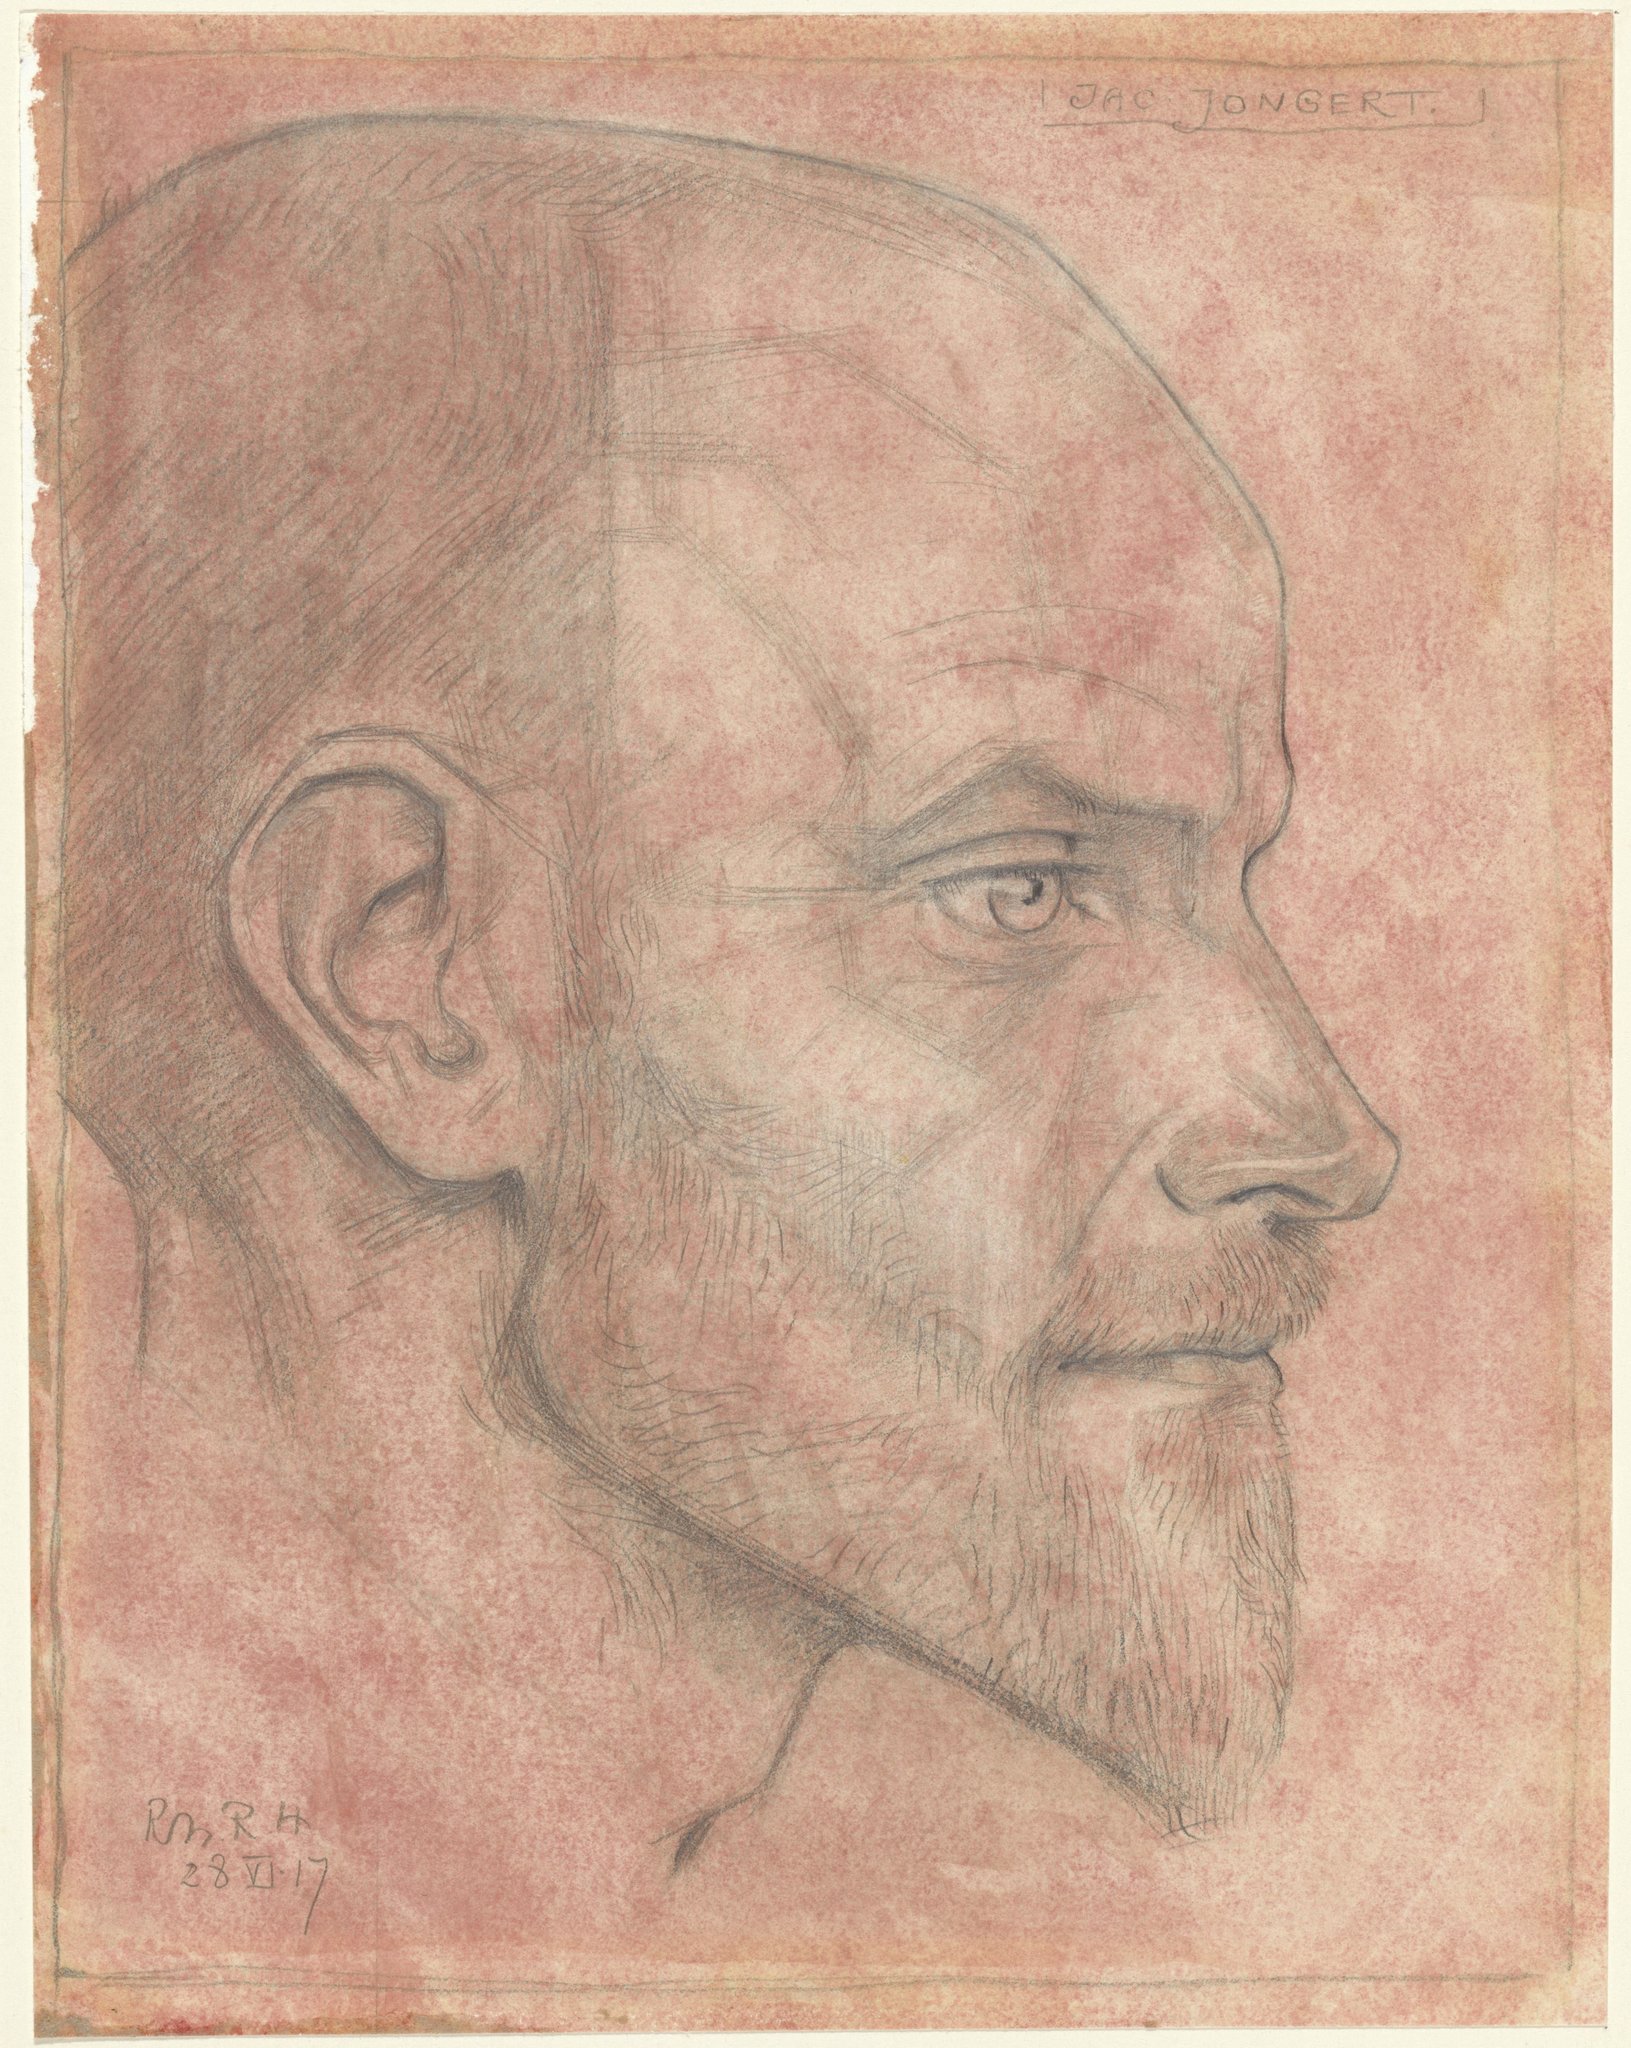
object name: drawing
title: Portret van Jac. Jongert, van opzij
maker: richard nicolaüs roland holst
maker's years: 1868-1938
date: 1917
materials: pencil, paper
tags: jac jongert, historical persons, portrait, self-portrait of artist